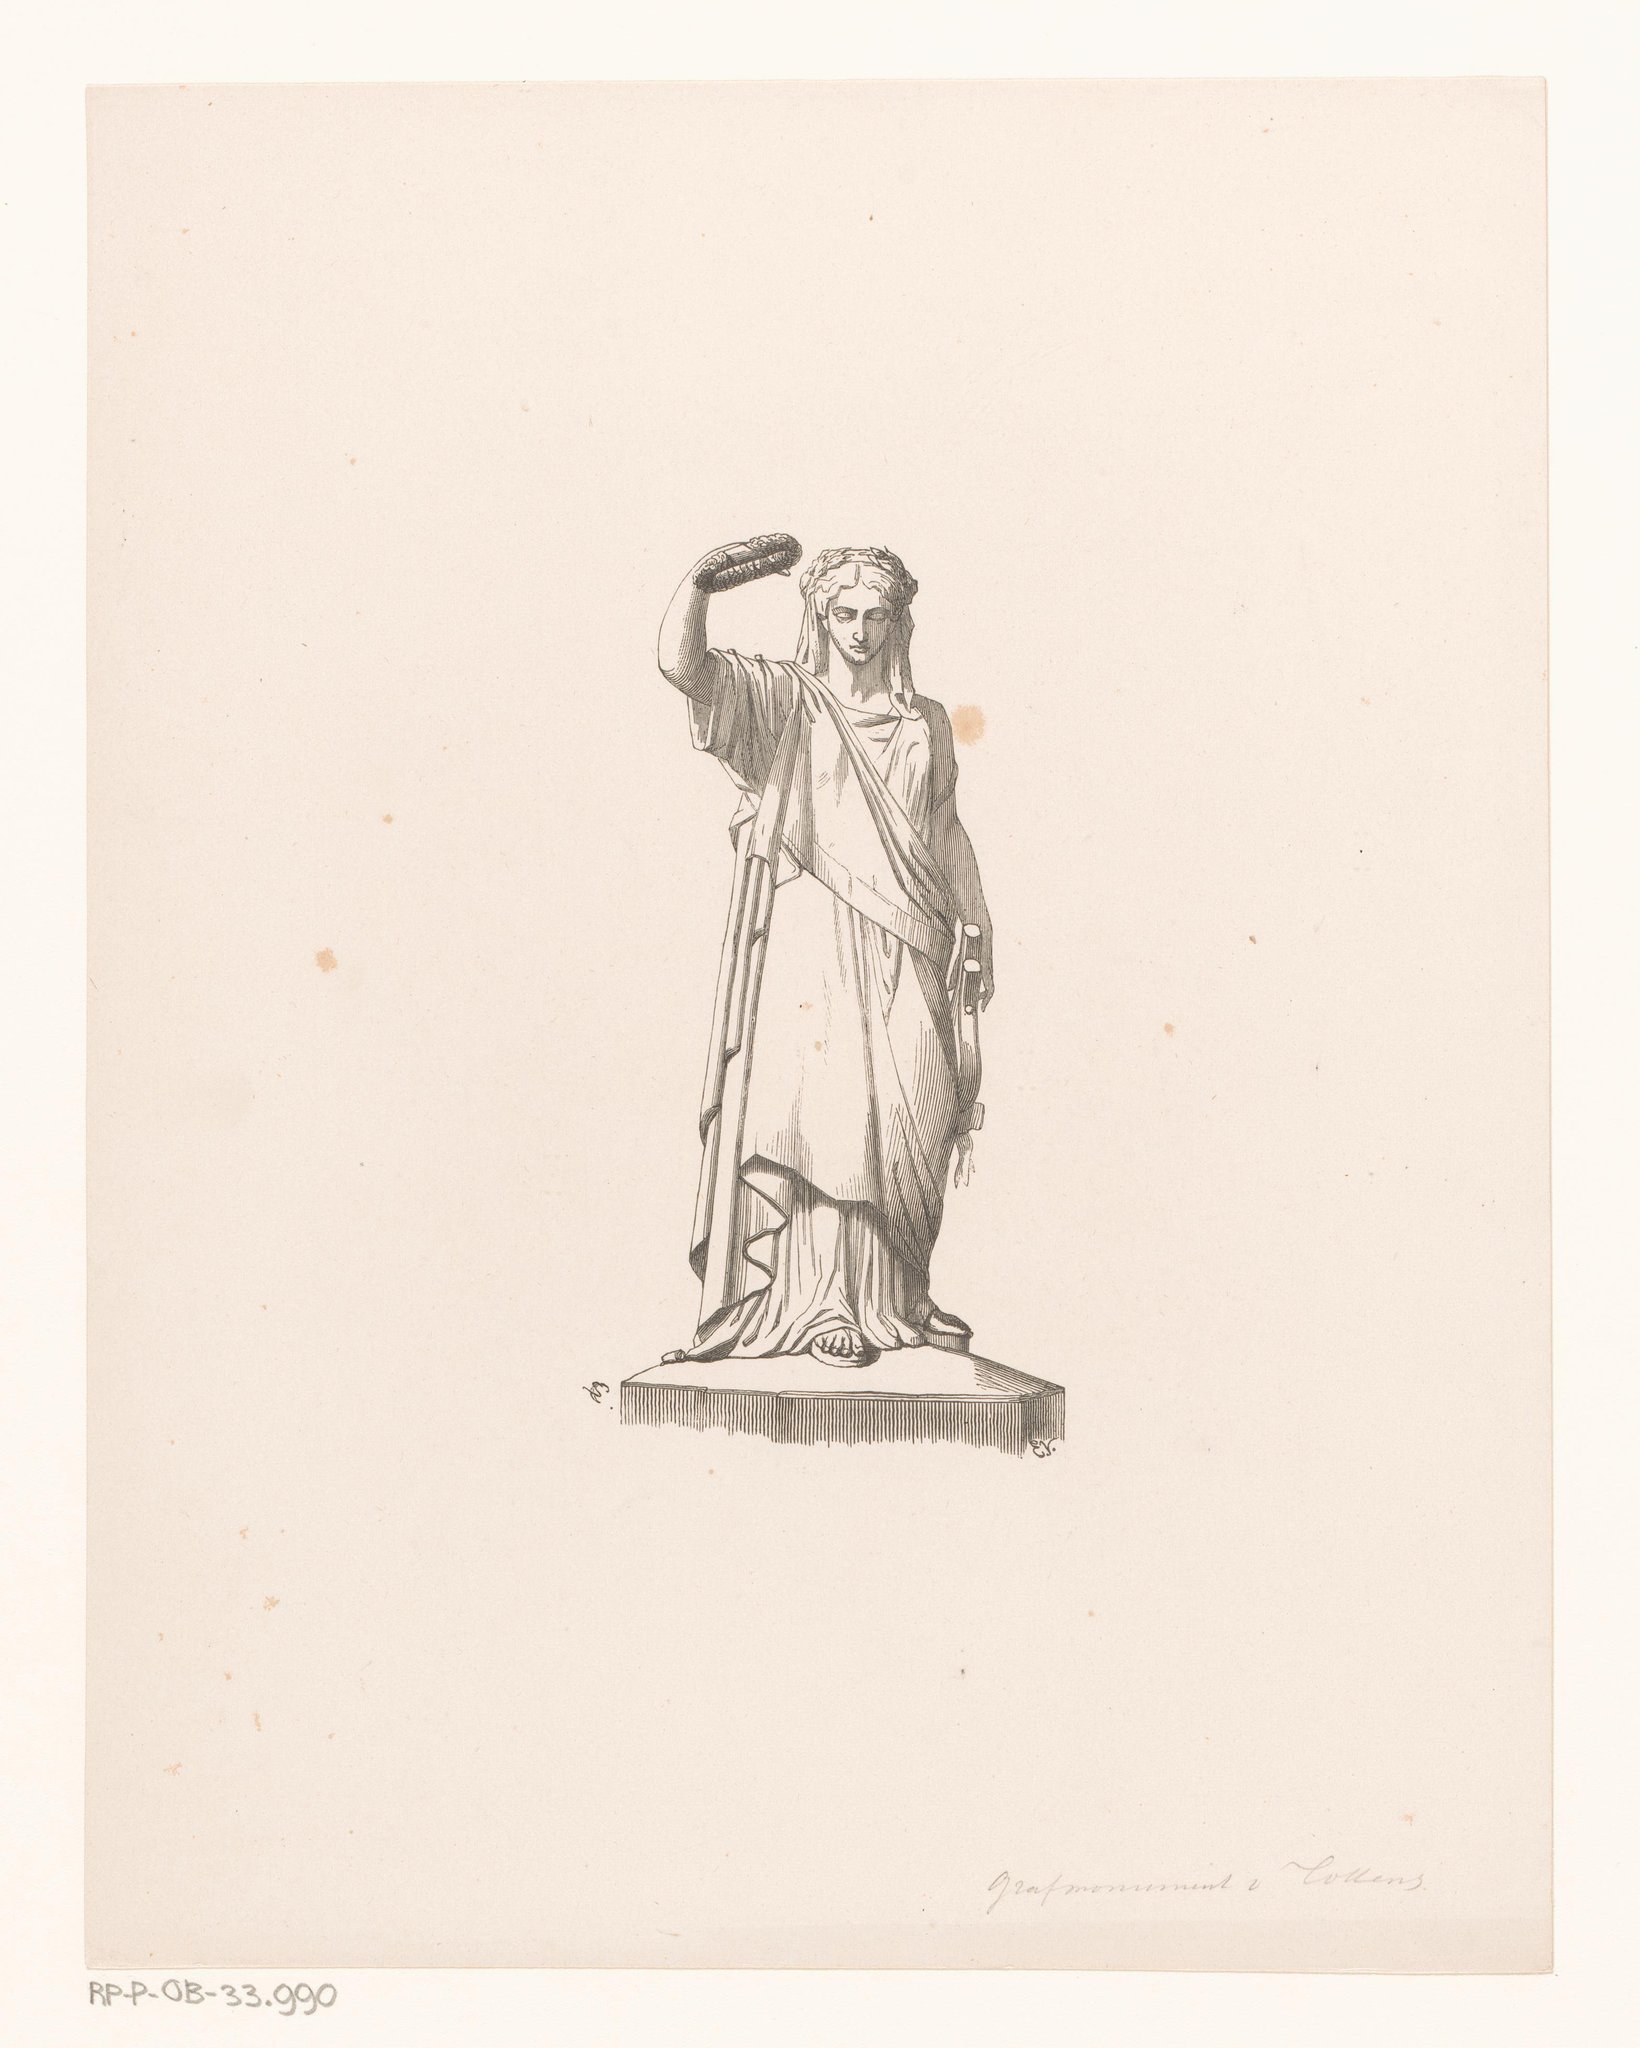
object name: print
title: Grafmonument van de dichter Hendrik Tollens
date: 1856-1906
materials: paper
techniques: engraving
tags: grave, tomb, fama as roman personification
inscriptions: collector's mark: Lugt 2228